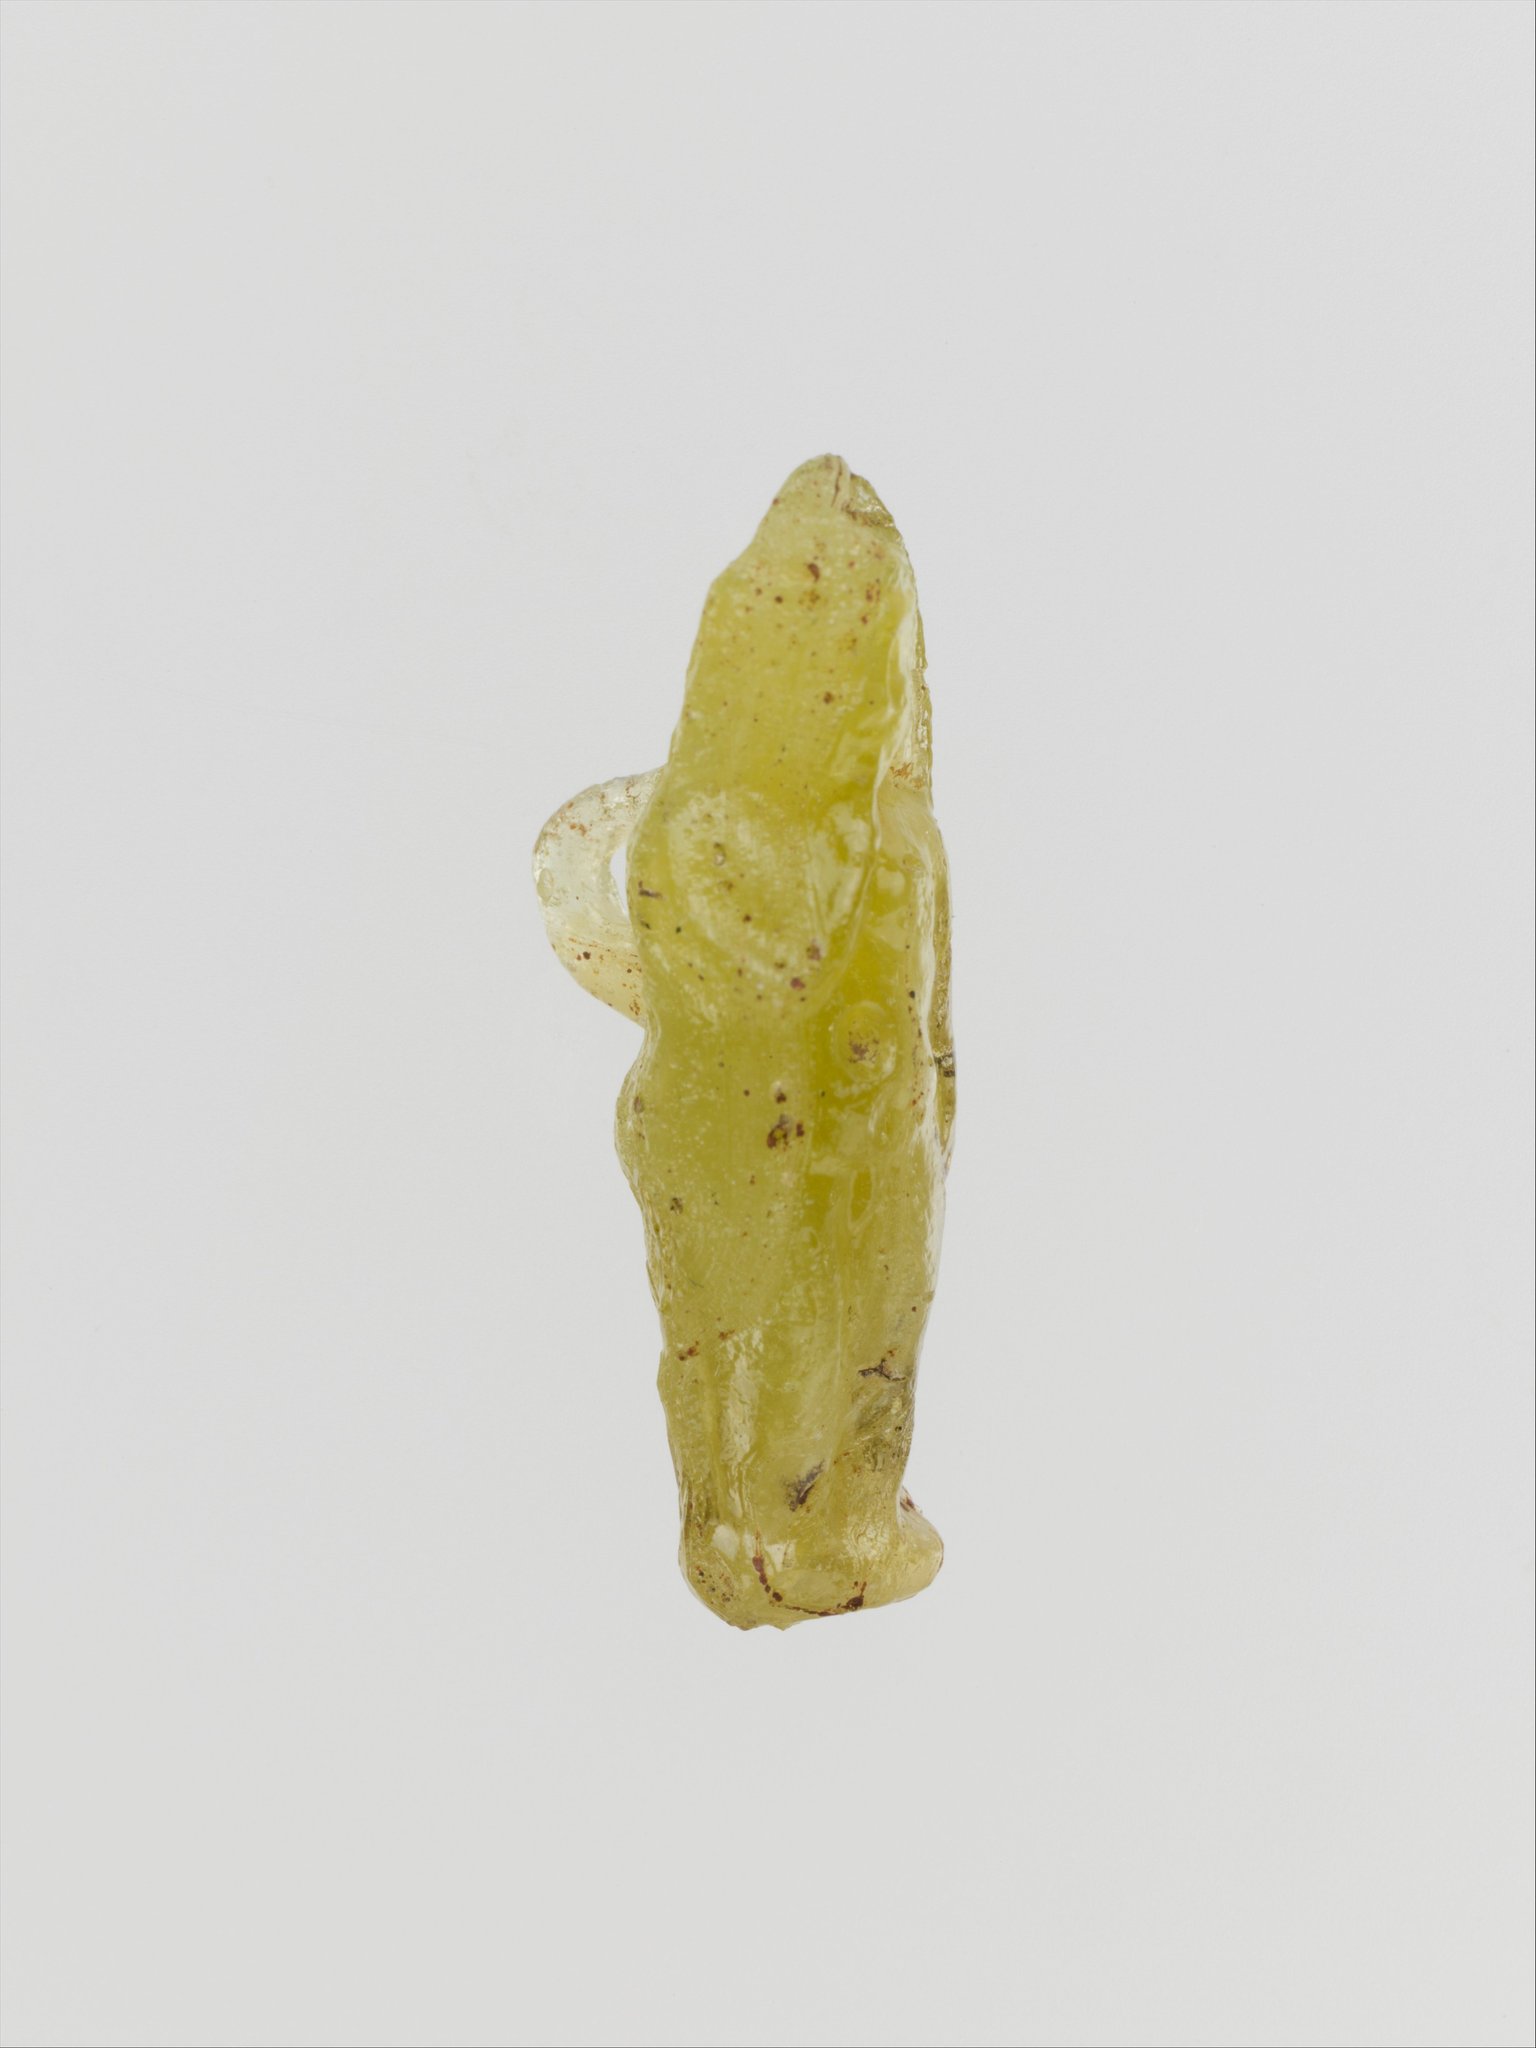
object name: pendant in the form of harpocrates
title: Glass pendant in the shape of Harpokrates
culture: greek, eastern mediterranean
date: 134-1 BCE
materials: glass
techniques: molding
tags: harpokrates